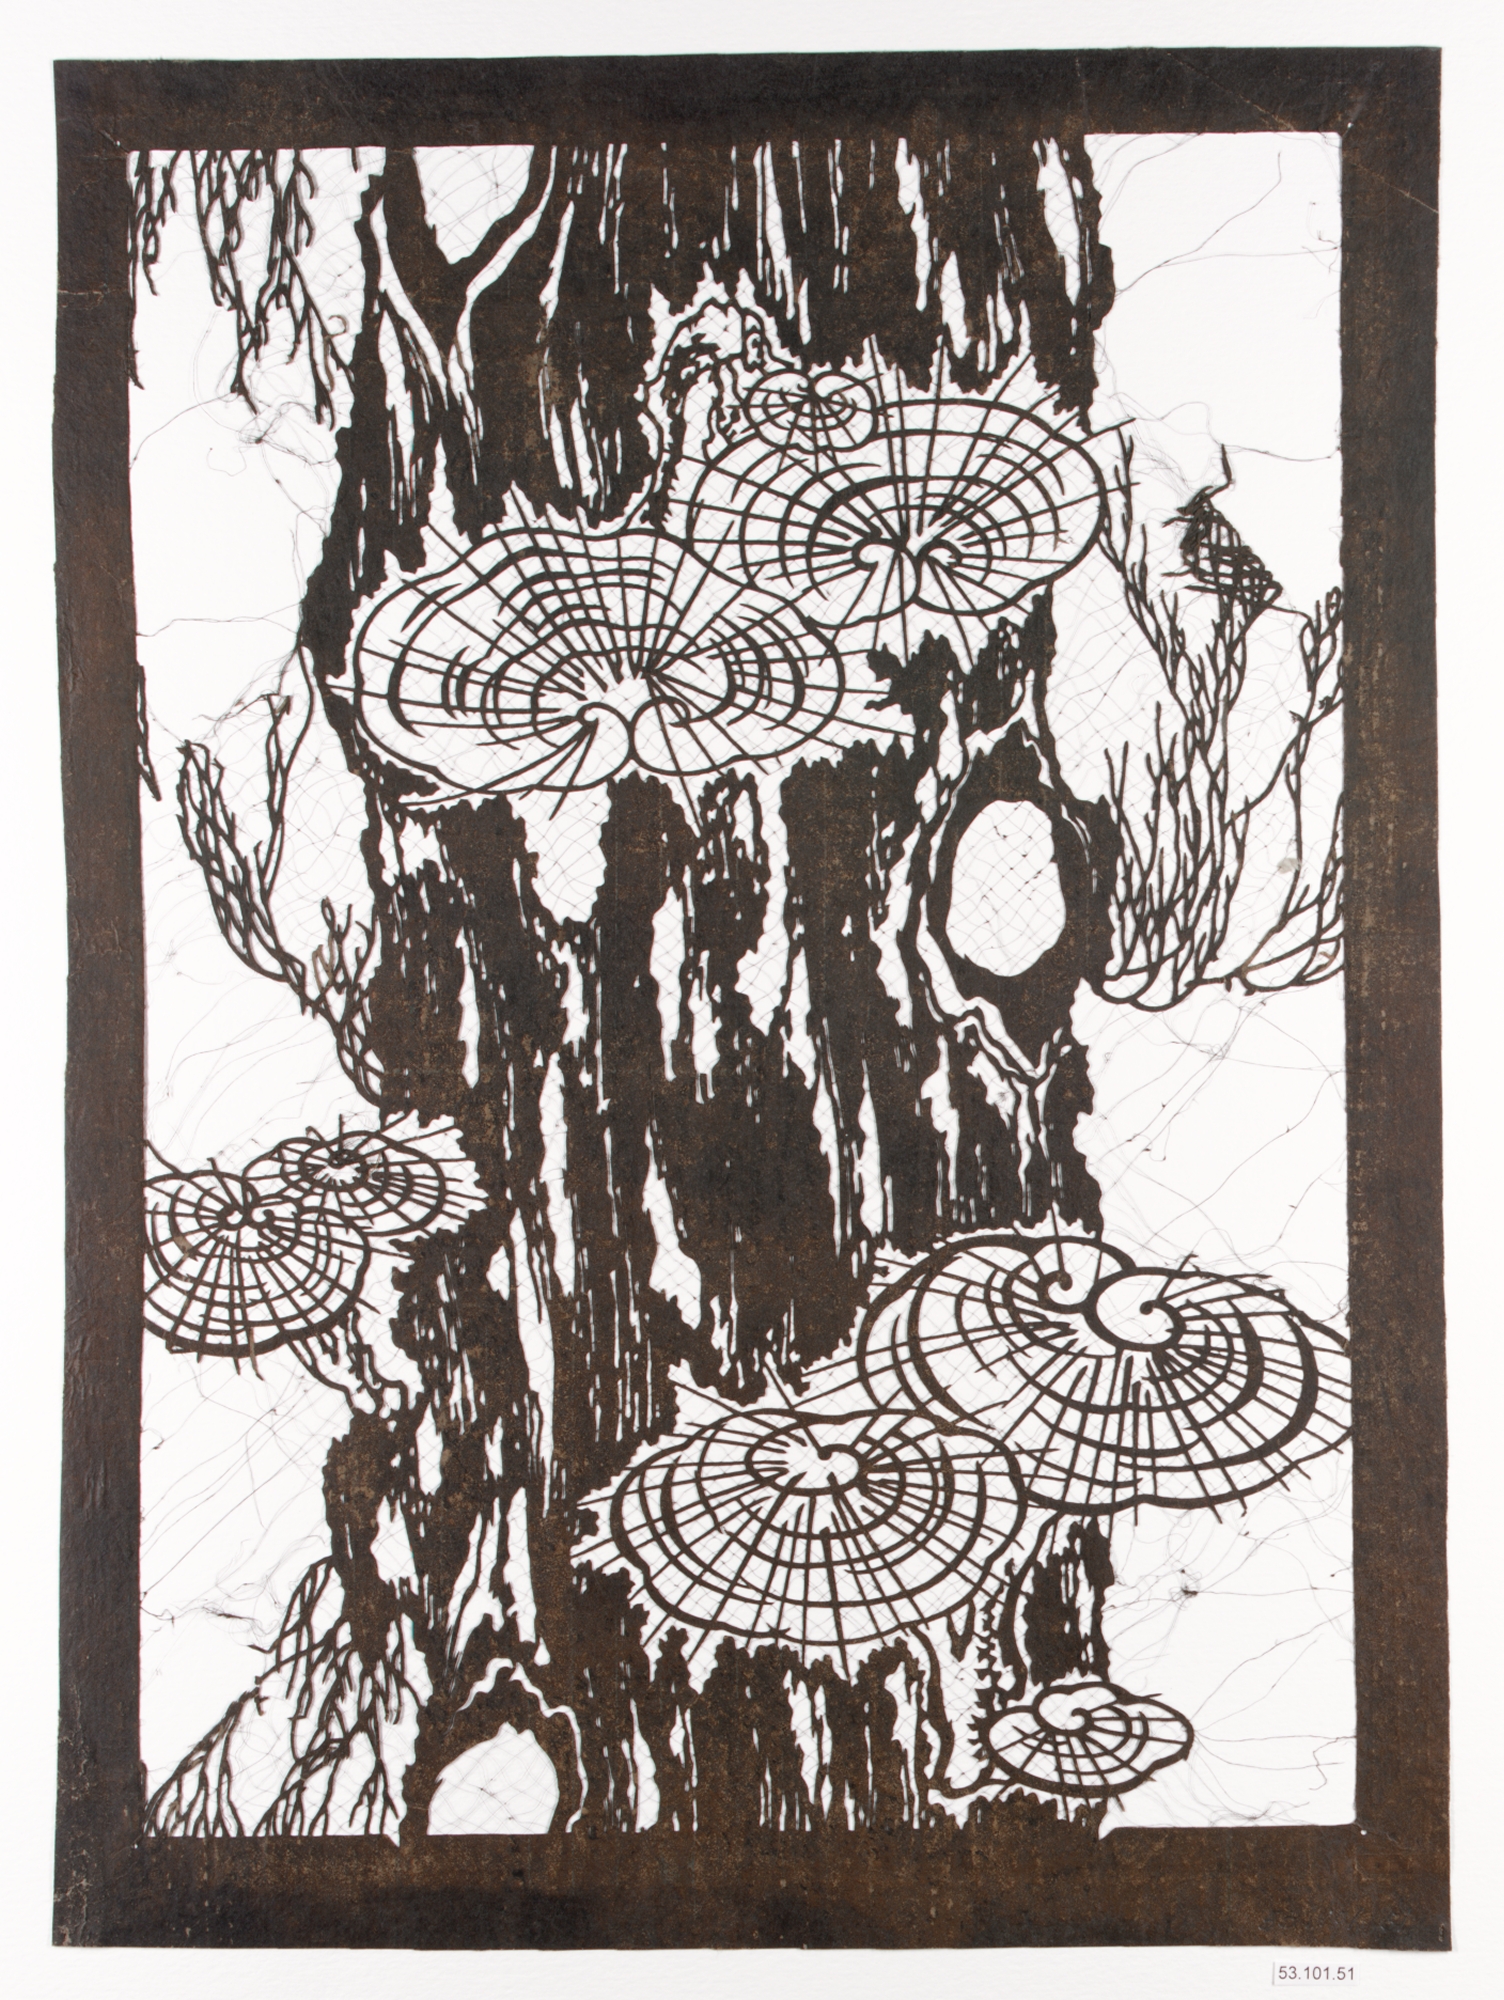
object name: stencil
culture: japanese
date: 1615-1868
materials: paper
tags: trees